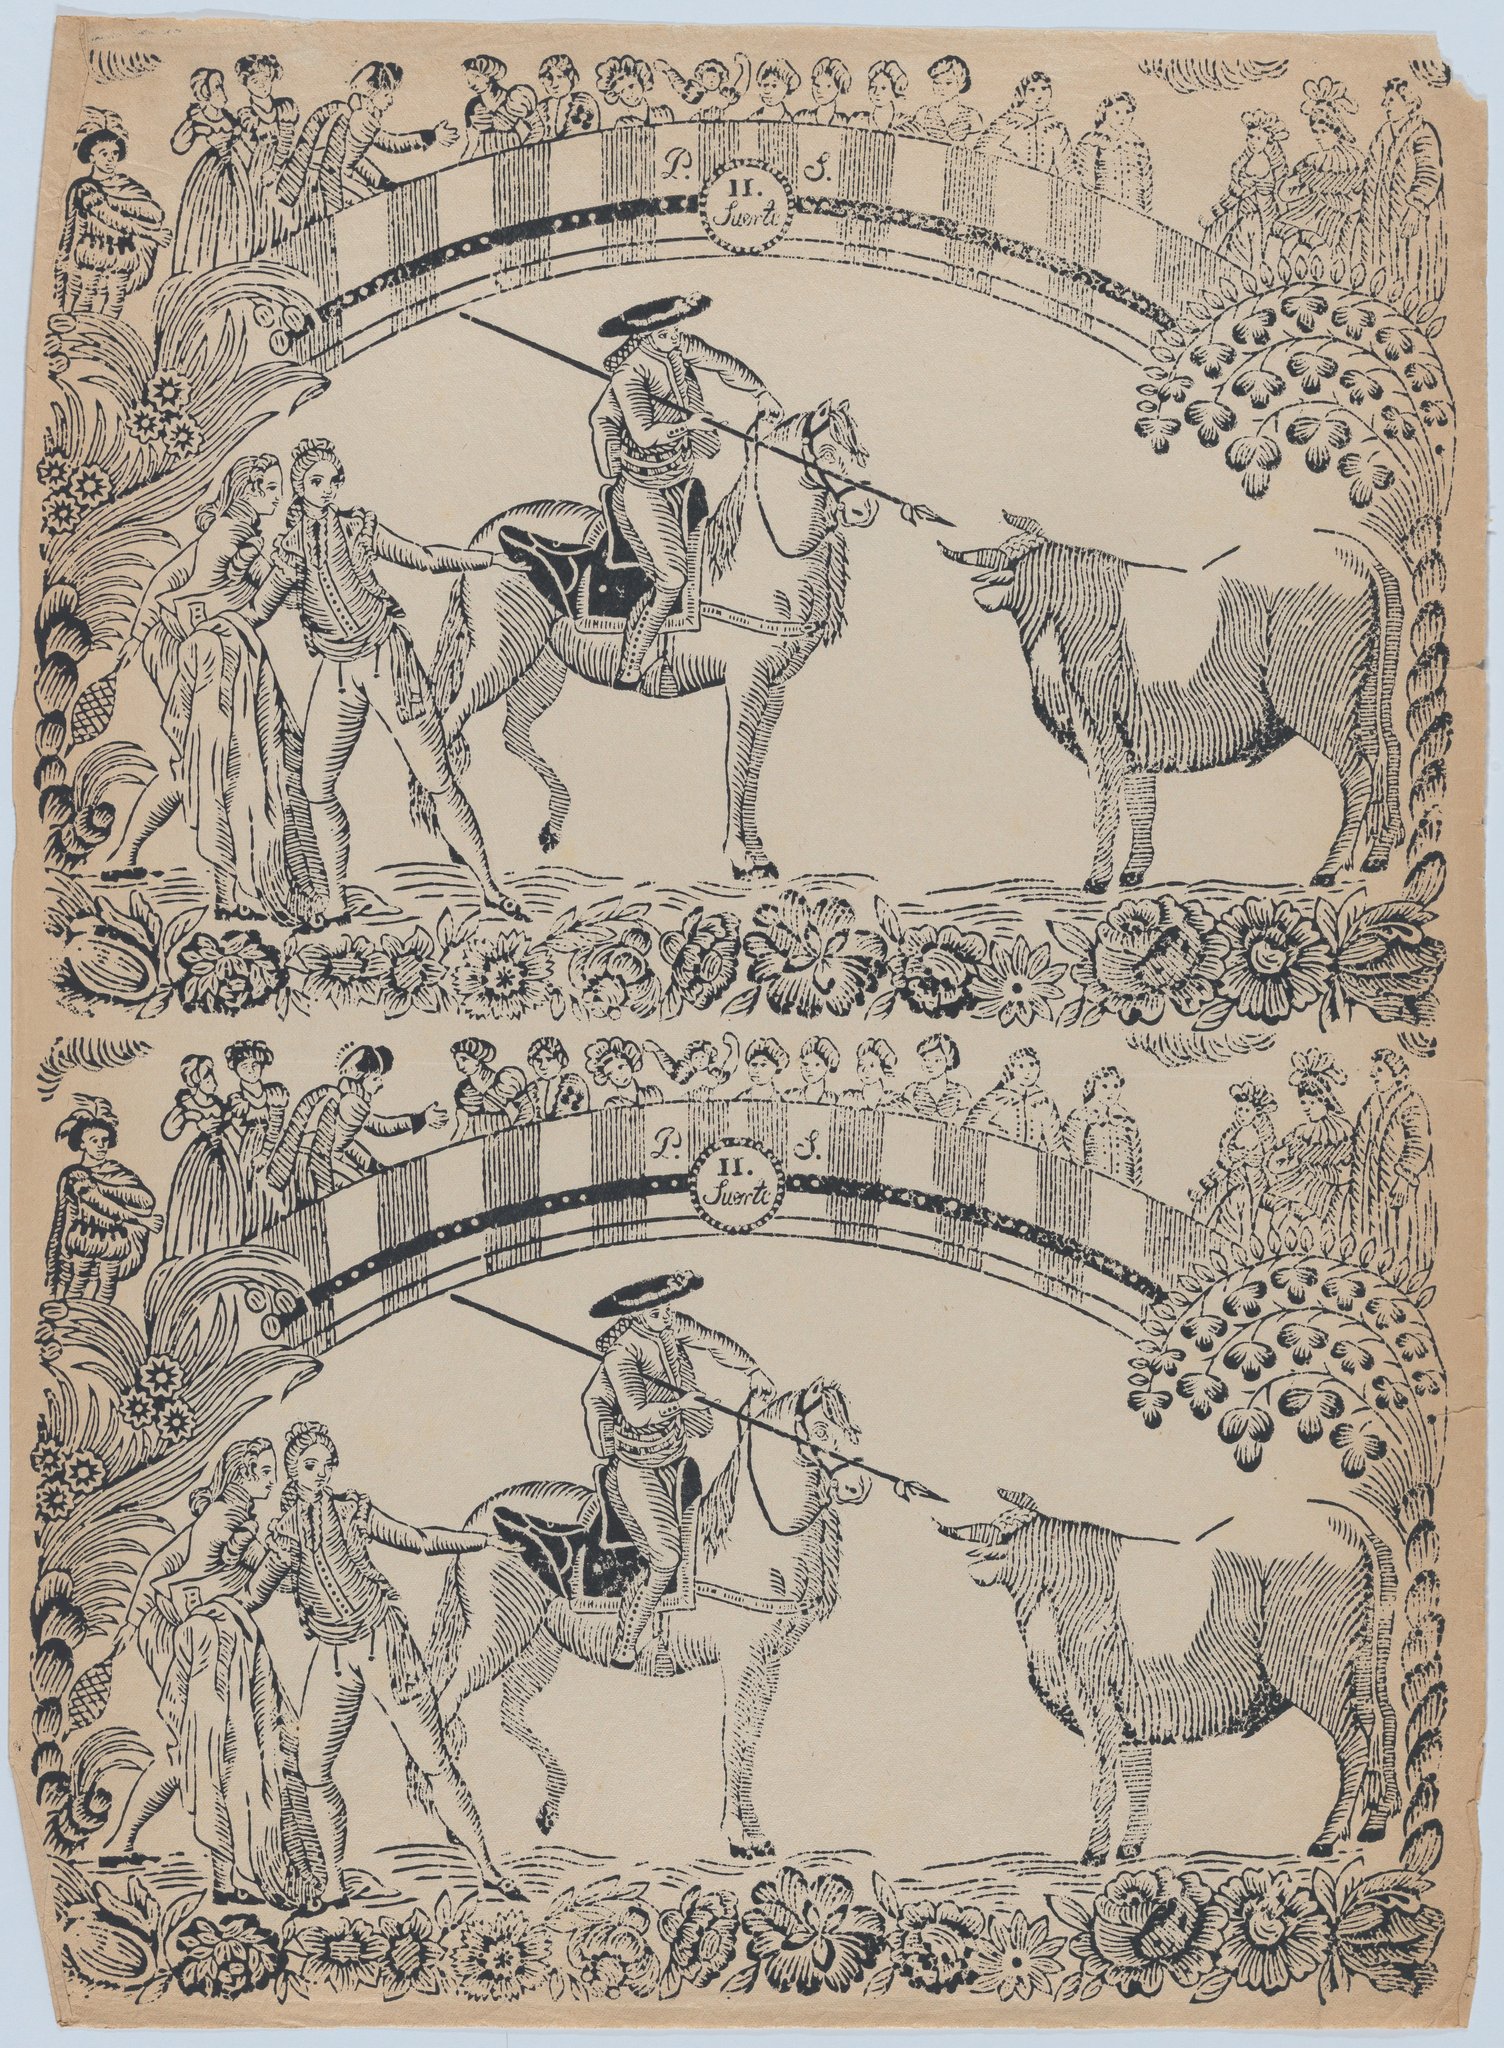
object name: print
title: Suerte II: Picador on horseback about to stab a bull with a pique; two toreros behind him to left (two impressions on the same sheet)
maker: anonymous, spanish, 19th century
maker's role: artist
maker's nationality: spanish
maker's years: 1800-1900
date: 1850-1880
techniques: woodcut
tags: men,women,bulls,horses,crowd